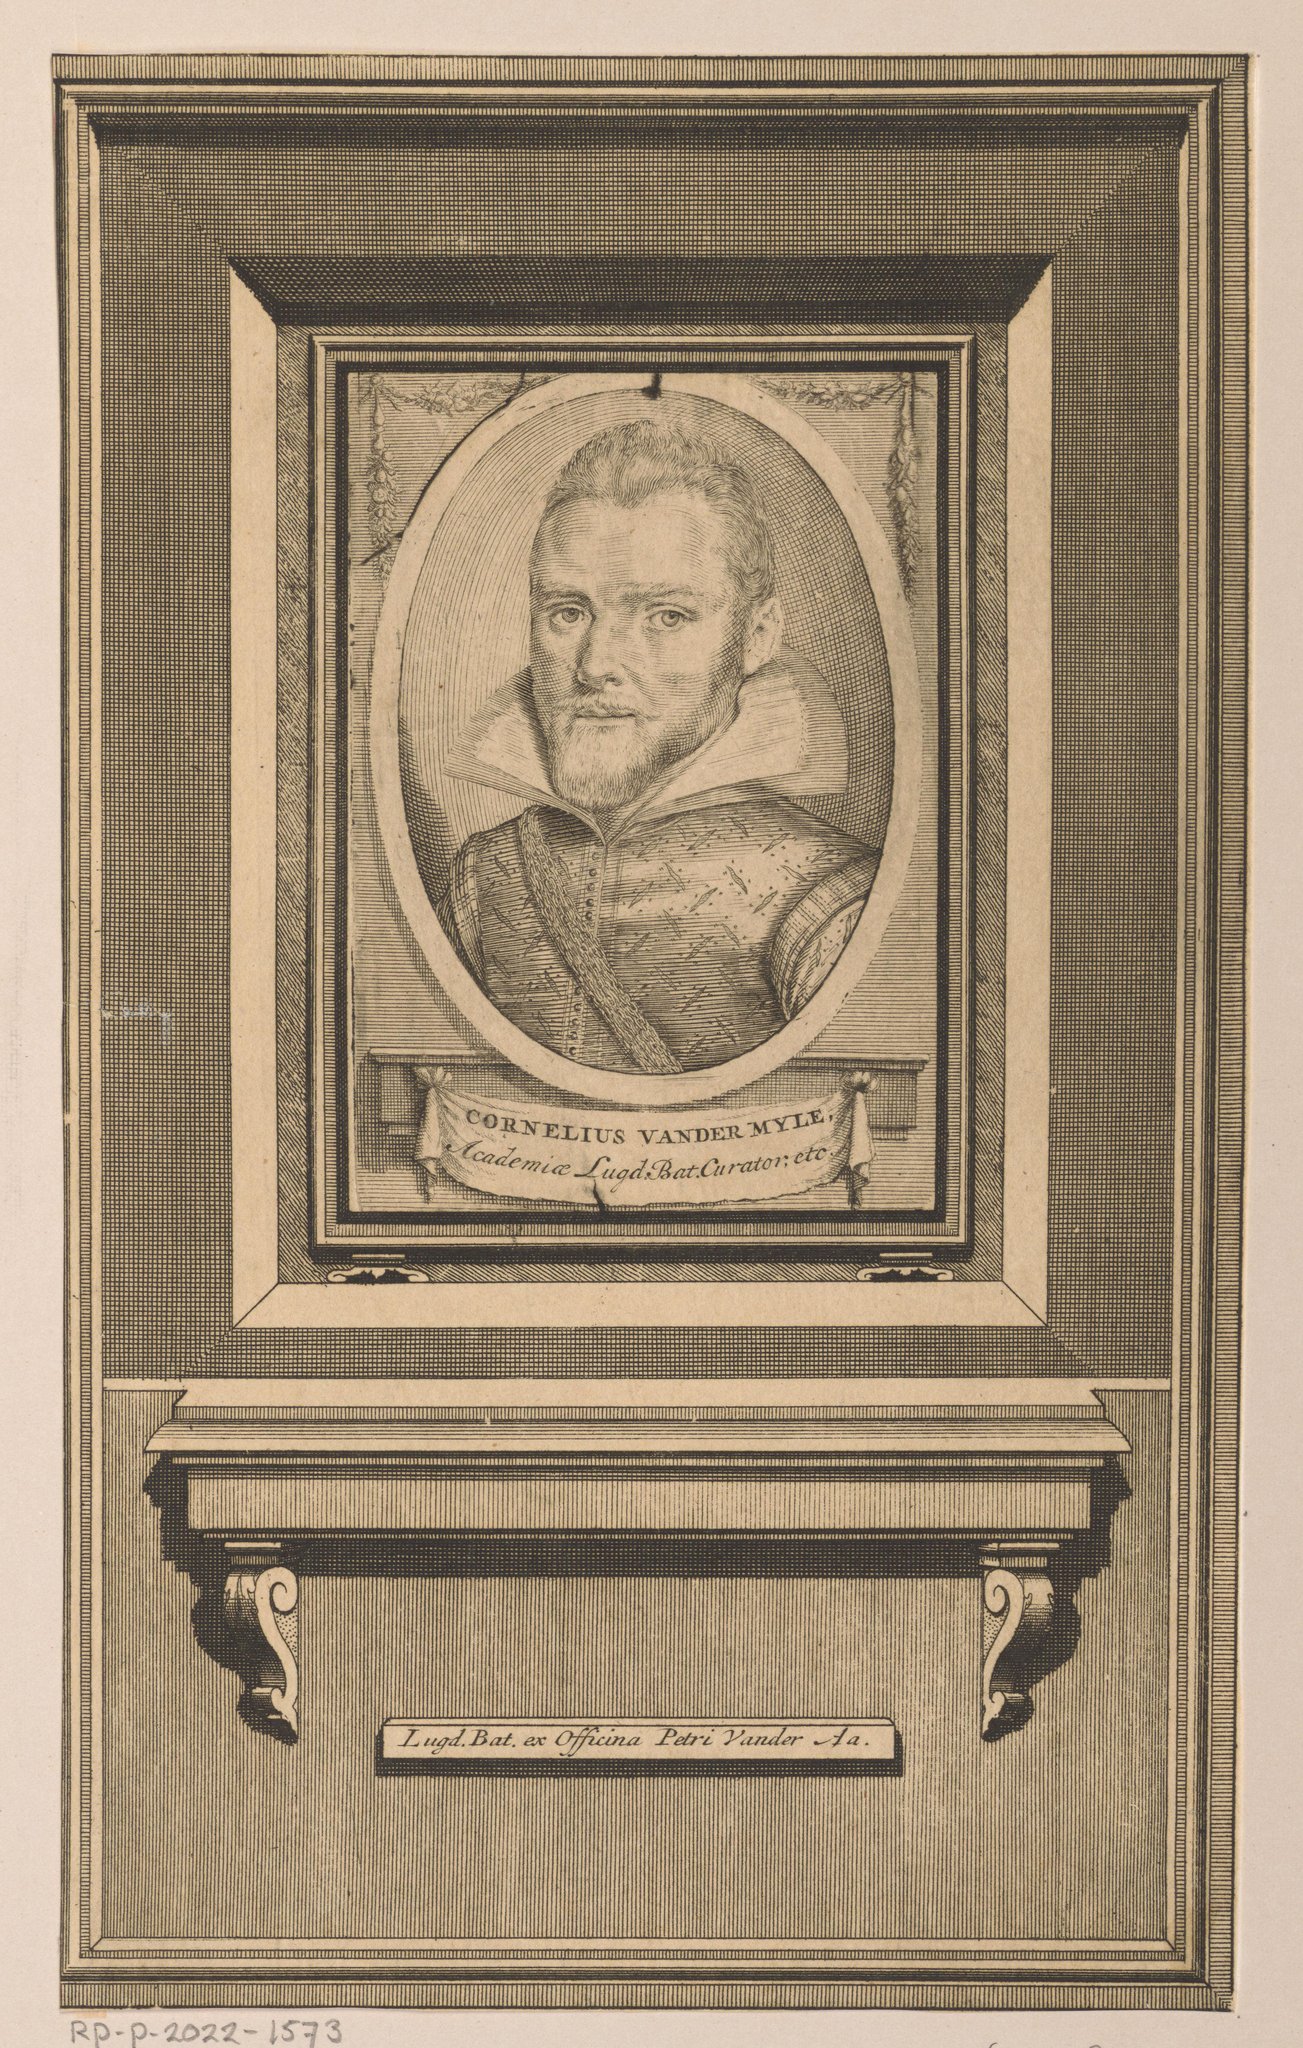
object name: print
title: Beroemde mannen aan de universiteit van Leiden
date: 1716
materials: paper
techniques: engraving, etching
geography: leiden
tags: the hague, politician, historical persons, politician, e.g. party leader, diplomacy, diplomat